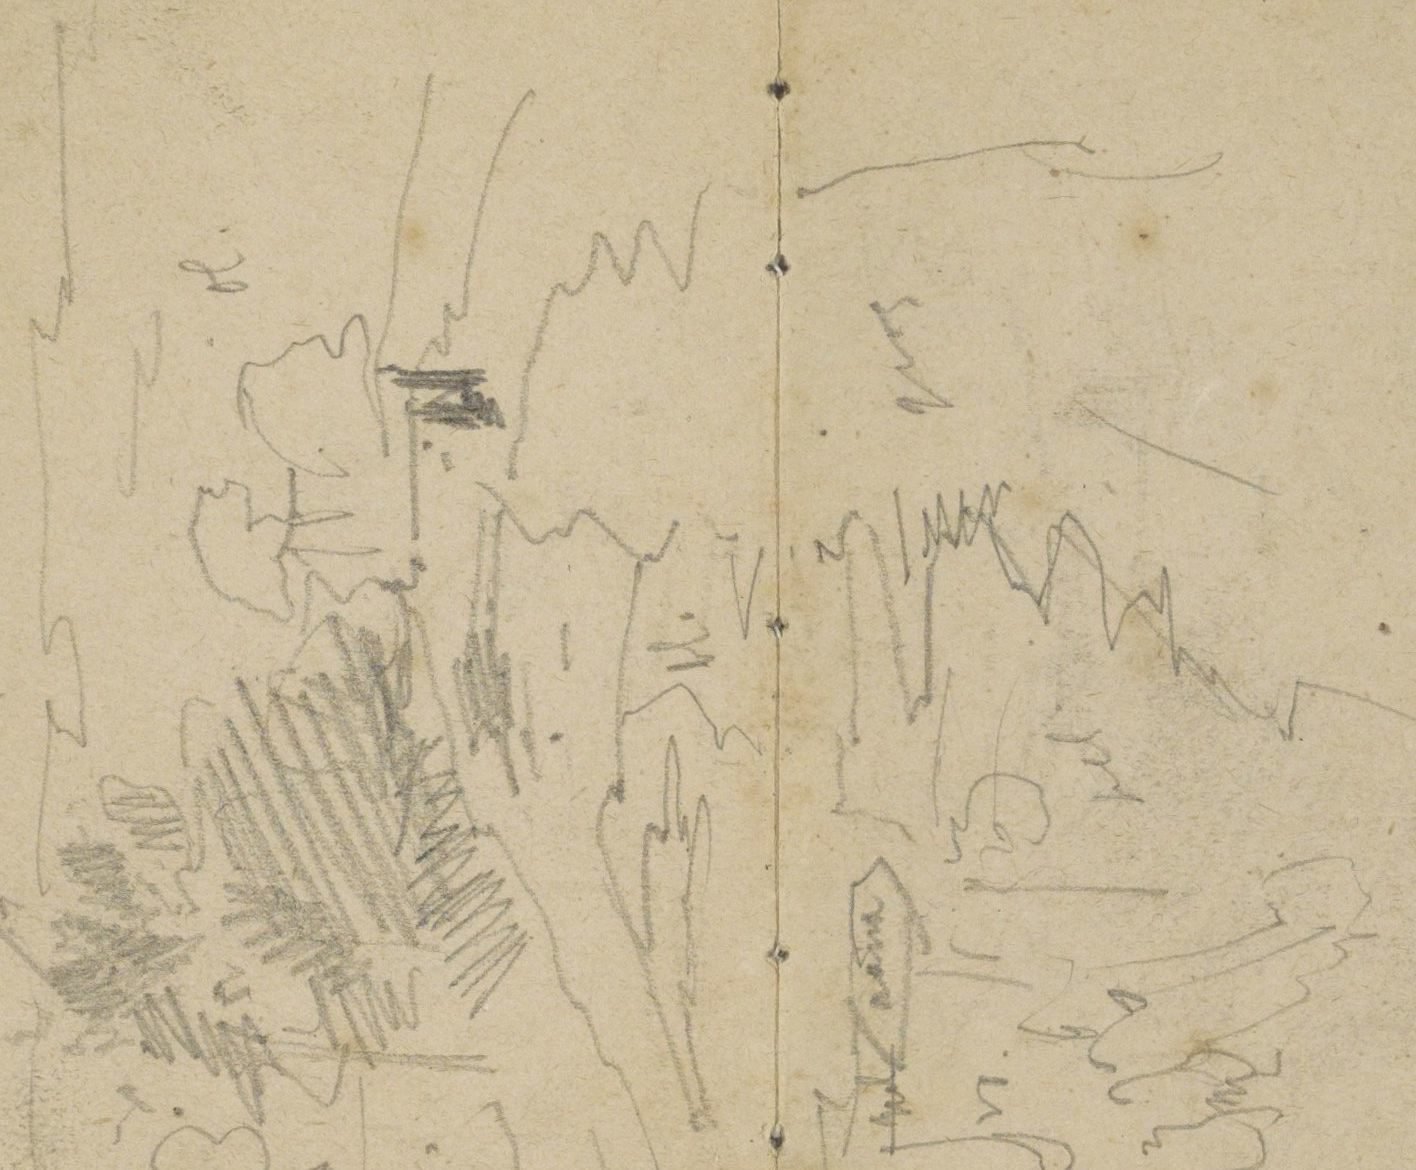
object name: sketchbook leaf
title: Landschap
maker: george hendrik breitner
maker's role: draughtsman, painter, print maker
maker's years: 1857-1923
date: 1881-1883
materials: paper, pencil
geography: south holland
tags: landscapes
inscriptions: annotation: ‘land/ water’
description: Landschap. Pagina 60 en pagina 61 uit een schetsboek met 43 bladen.